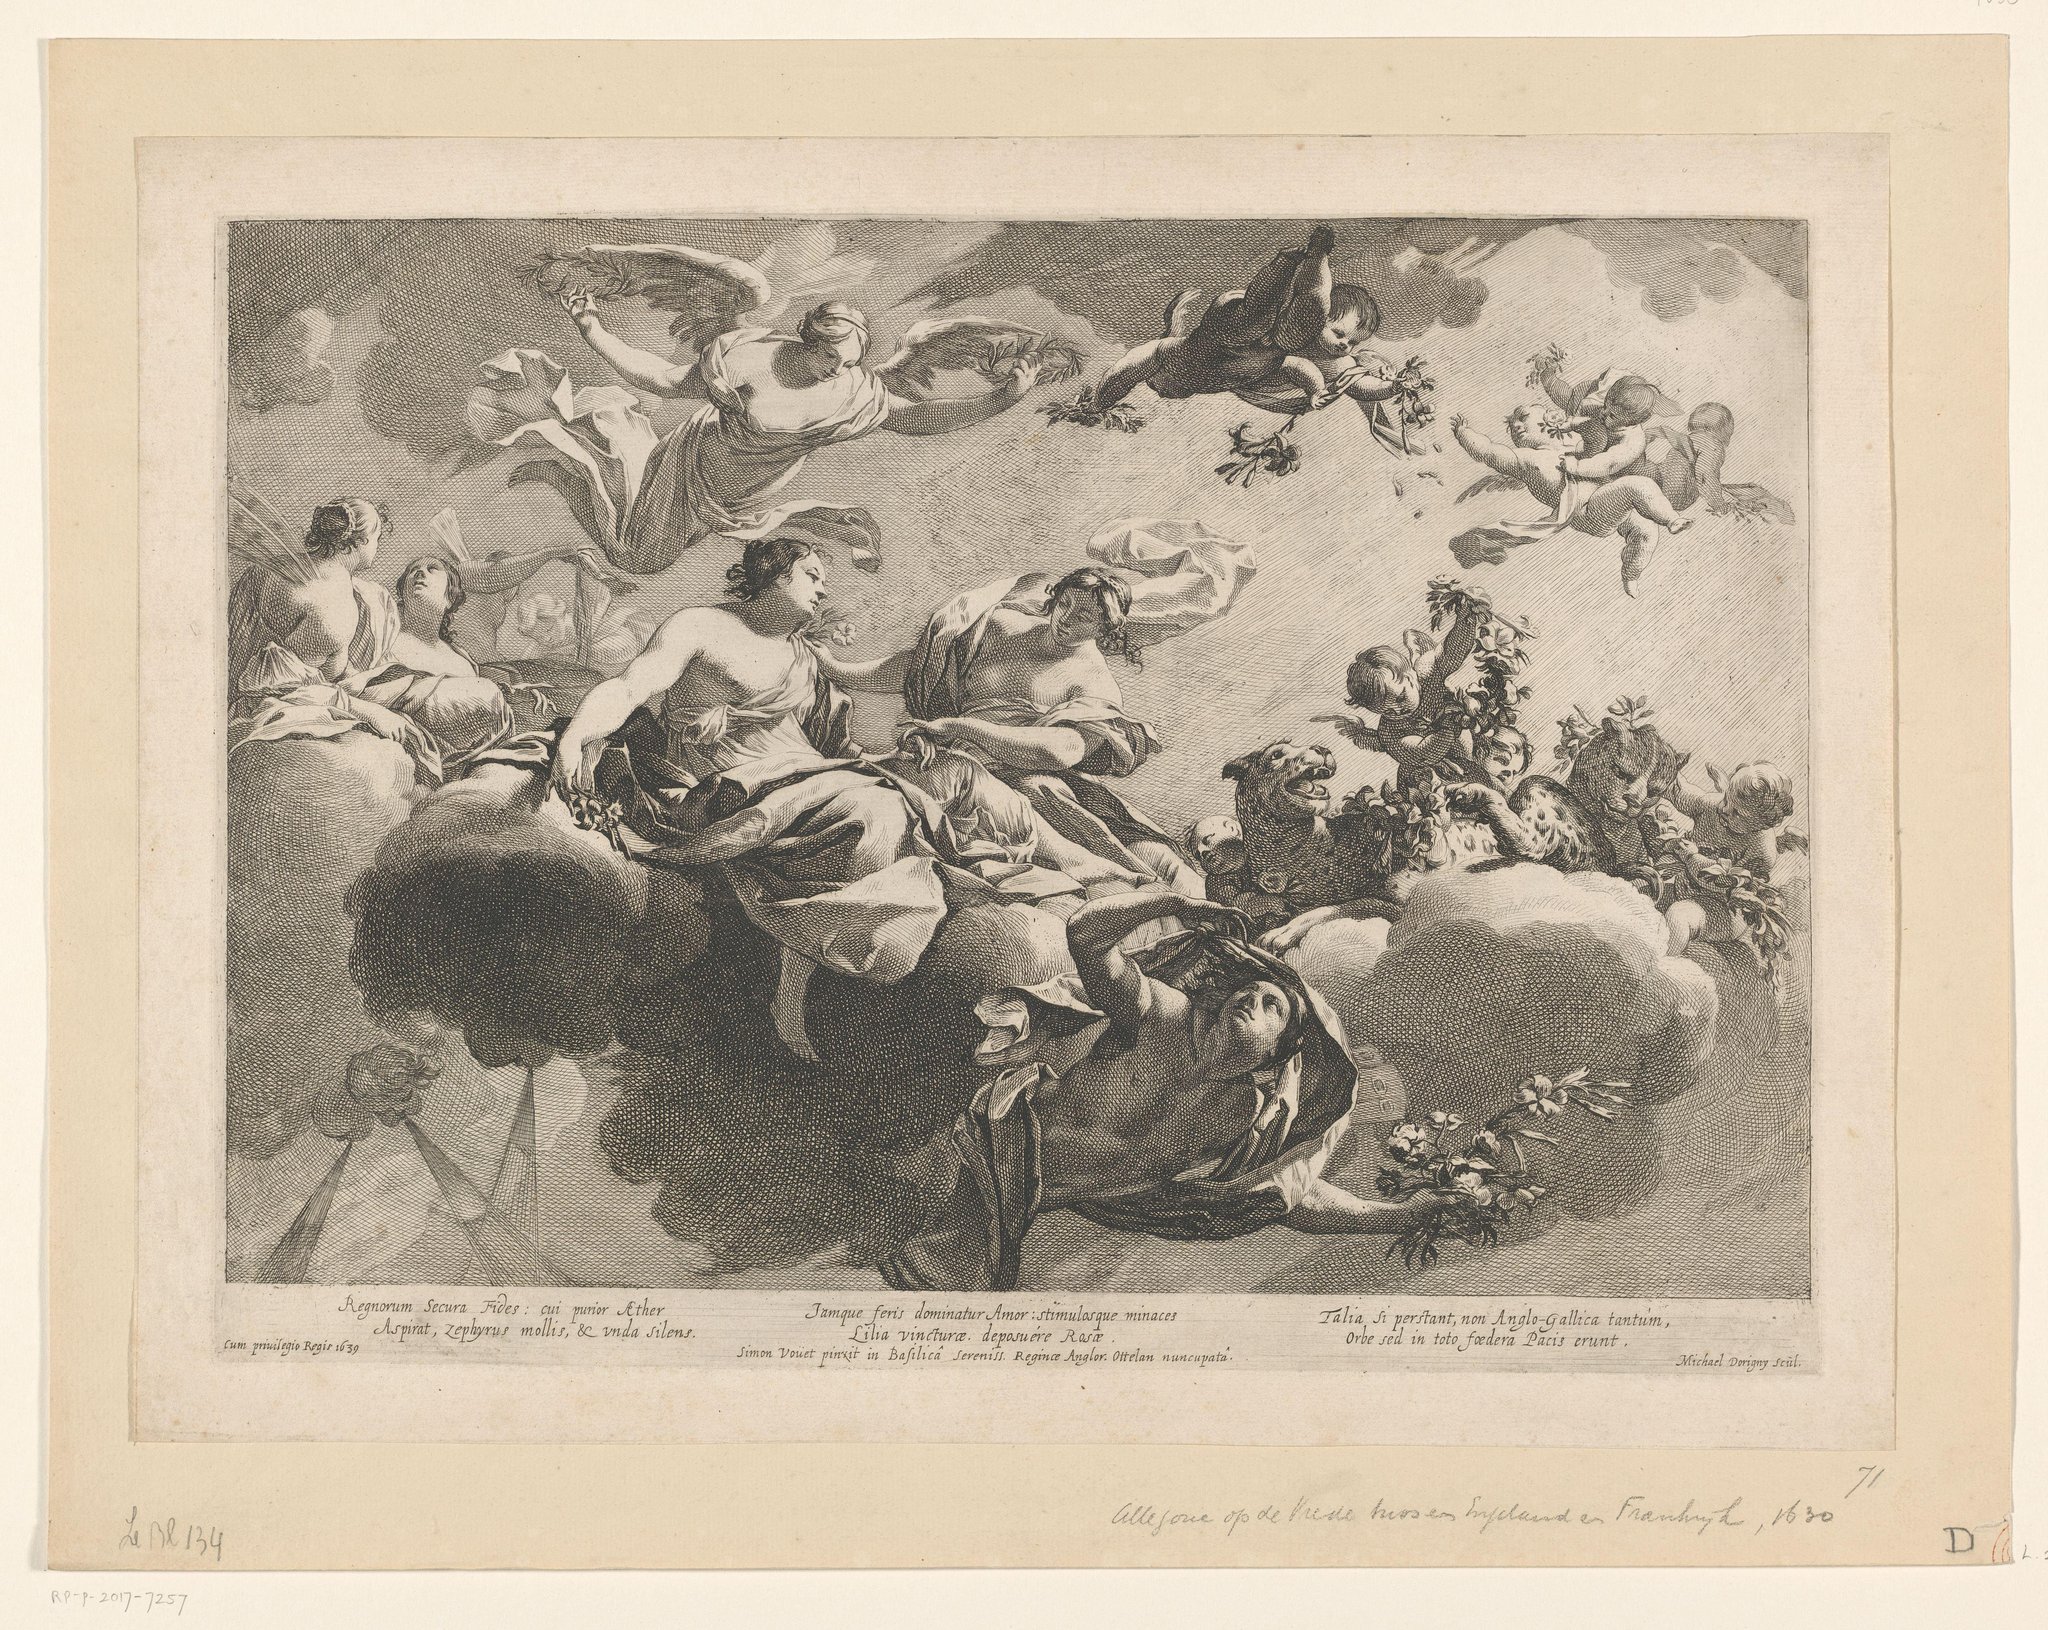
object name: print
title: Allegorie op de Vrede tussen Frankrijk en Engeland, ca. 1630 (?)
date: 1639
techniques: engraving, etching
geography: france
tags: symbols, allegories of peace, 'pax'; 'pace' (ripa), france, england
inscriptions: collector's mark: Lugt 240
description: Allegorie op de vrede tussen Frankrijk en Engeland, ca. 1630 (?). Naar een beschilderd plafond in Engeland. Allegorische vrouwenfiguren (personificaties van Frankrijk en Engeland?) in de wolken, putti met bloemen (Engelse roze en Franse lelies), rechts twee luipaarden. Met zesregelig Frans onderschrift.